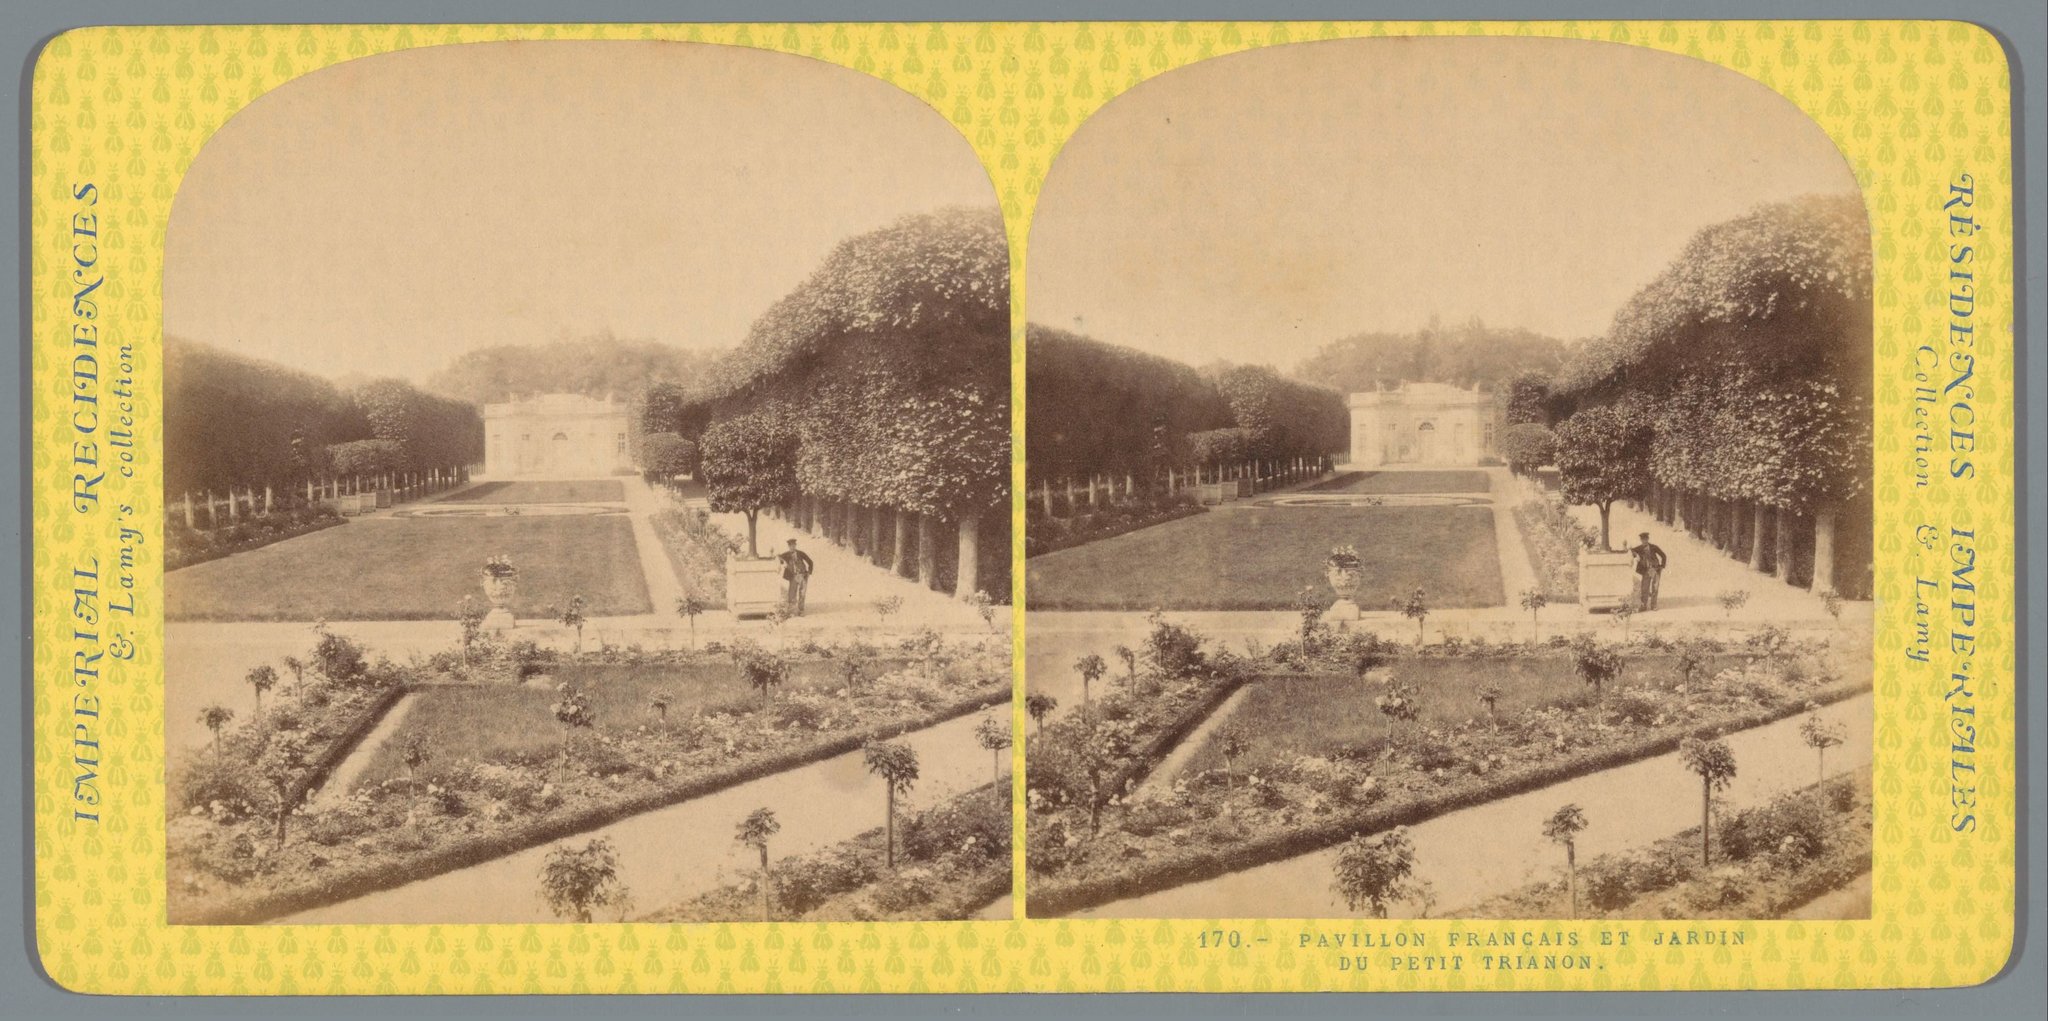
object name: stereograph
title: Gezicht op het Pavillon Français en de tuin van het Petit Trianon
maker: ernest eléonor pierre lamy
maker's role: publisher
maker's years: 1828-1900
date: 1860-1880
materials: cardboard, photographic support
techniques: albumen print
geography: versailles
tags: garden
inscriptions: number: ‘170.’, inscription: ‘E. Lamy's collection’